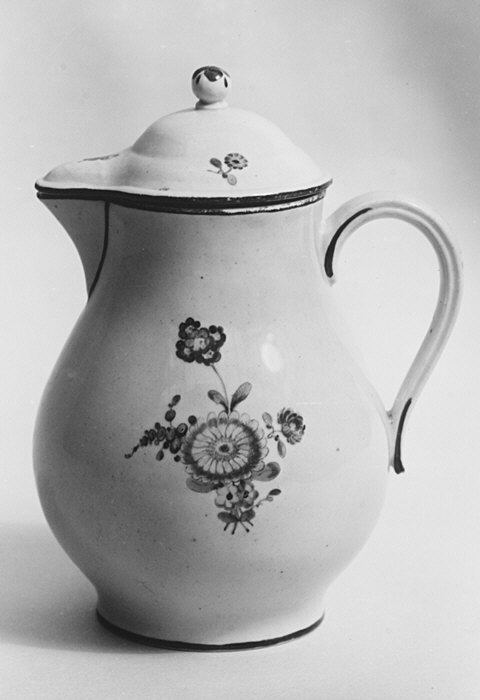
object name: coffeepot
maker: pfalz-zweibrücken porcelain manufactory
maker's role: manufactory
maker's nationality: german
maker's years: 1767-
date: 1770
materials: hard paste porcelain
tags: flowers